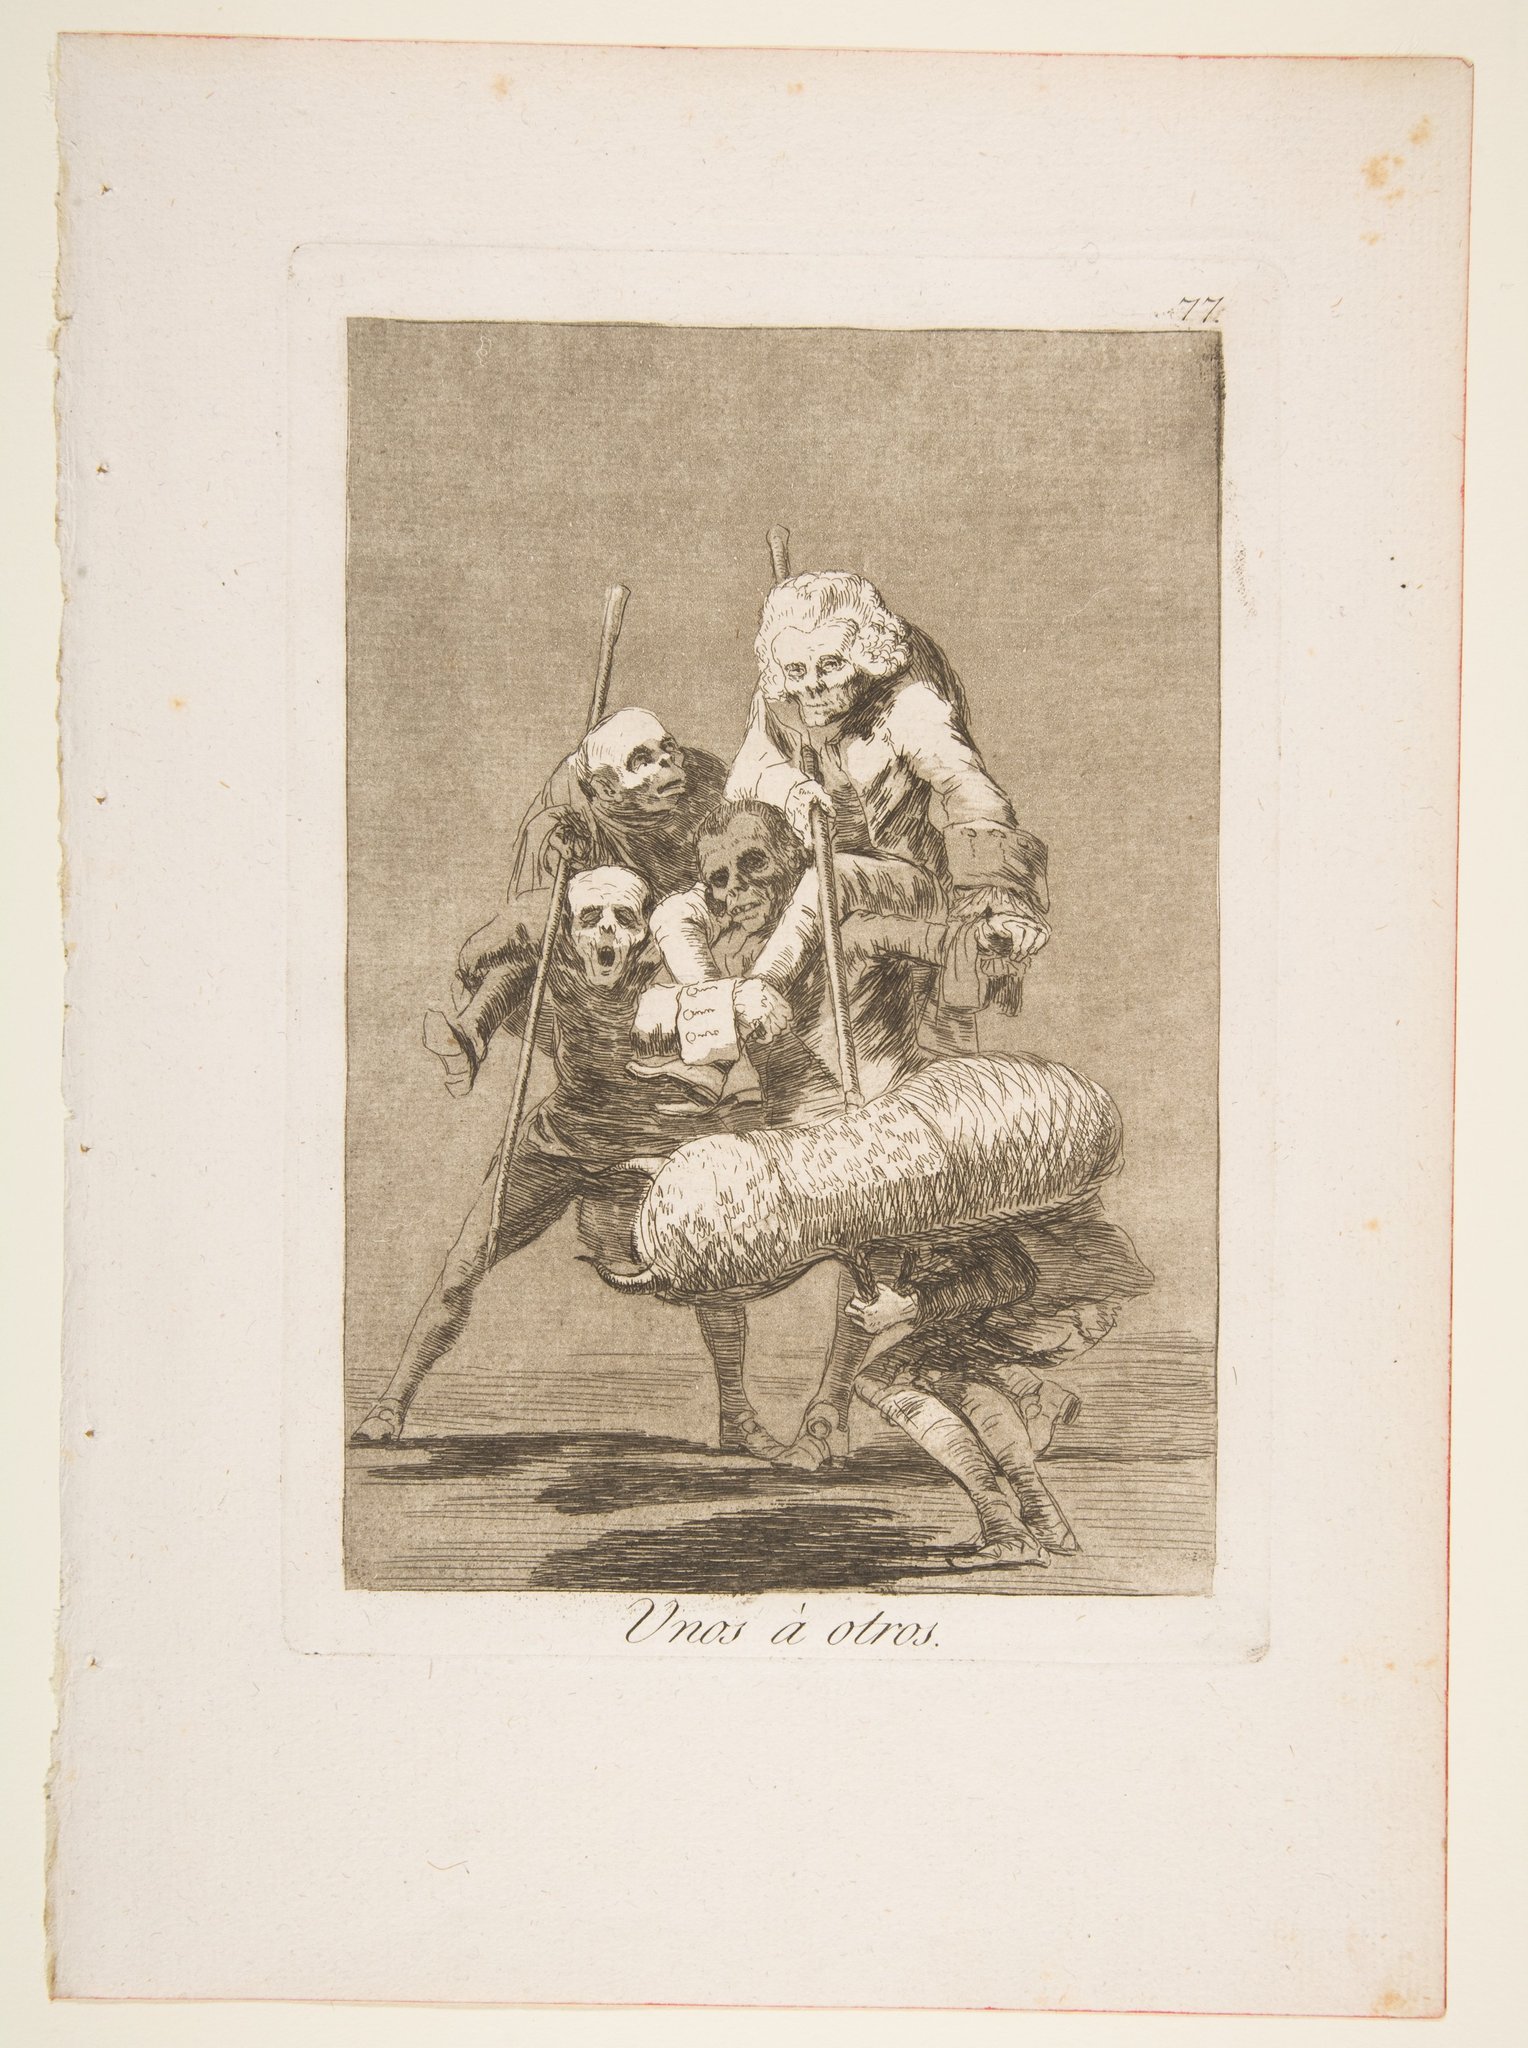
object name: print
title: Plate 77 from "Los Caprichos": What one does to another (Unos á otros)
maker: goya (francisco de goya y lucientes)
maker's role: artist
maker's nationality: spanish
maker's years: 1746-1828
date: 1799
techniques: aquatint, engraving, burnishing, drypoint, etching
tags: men